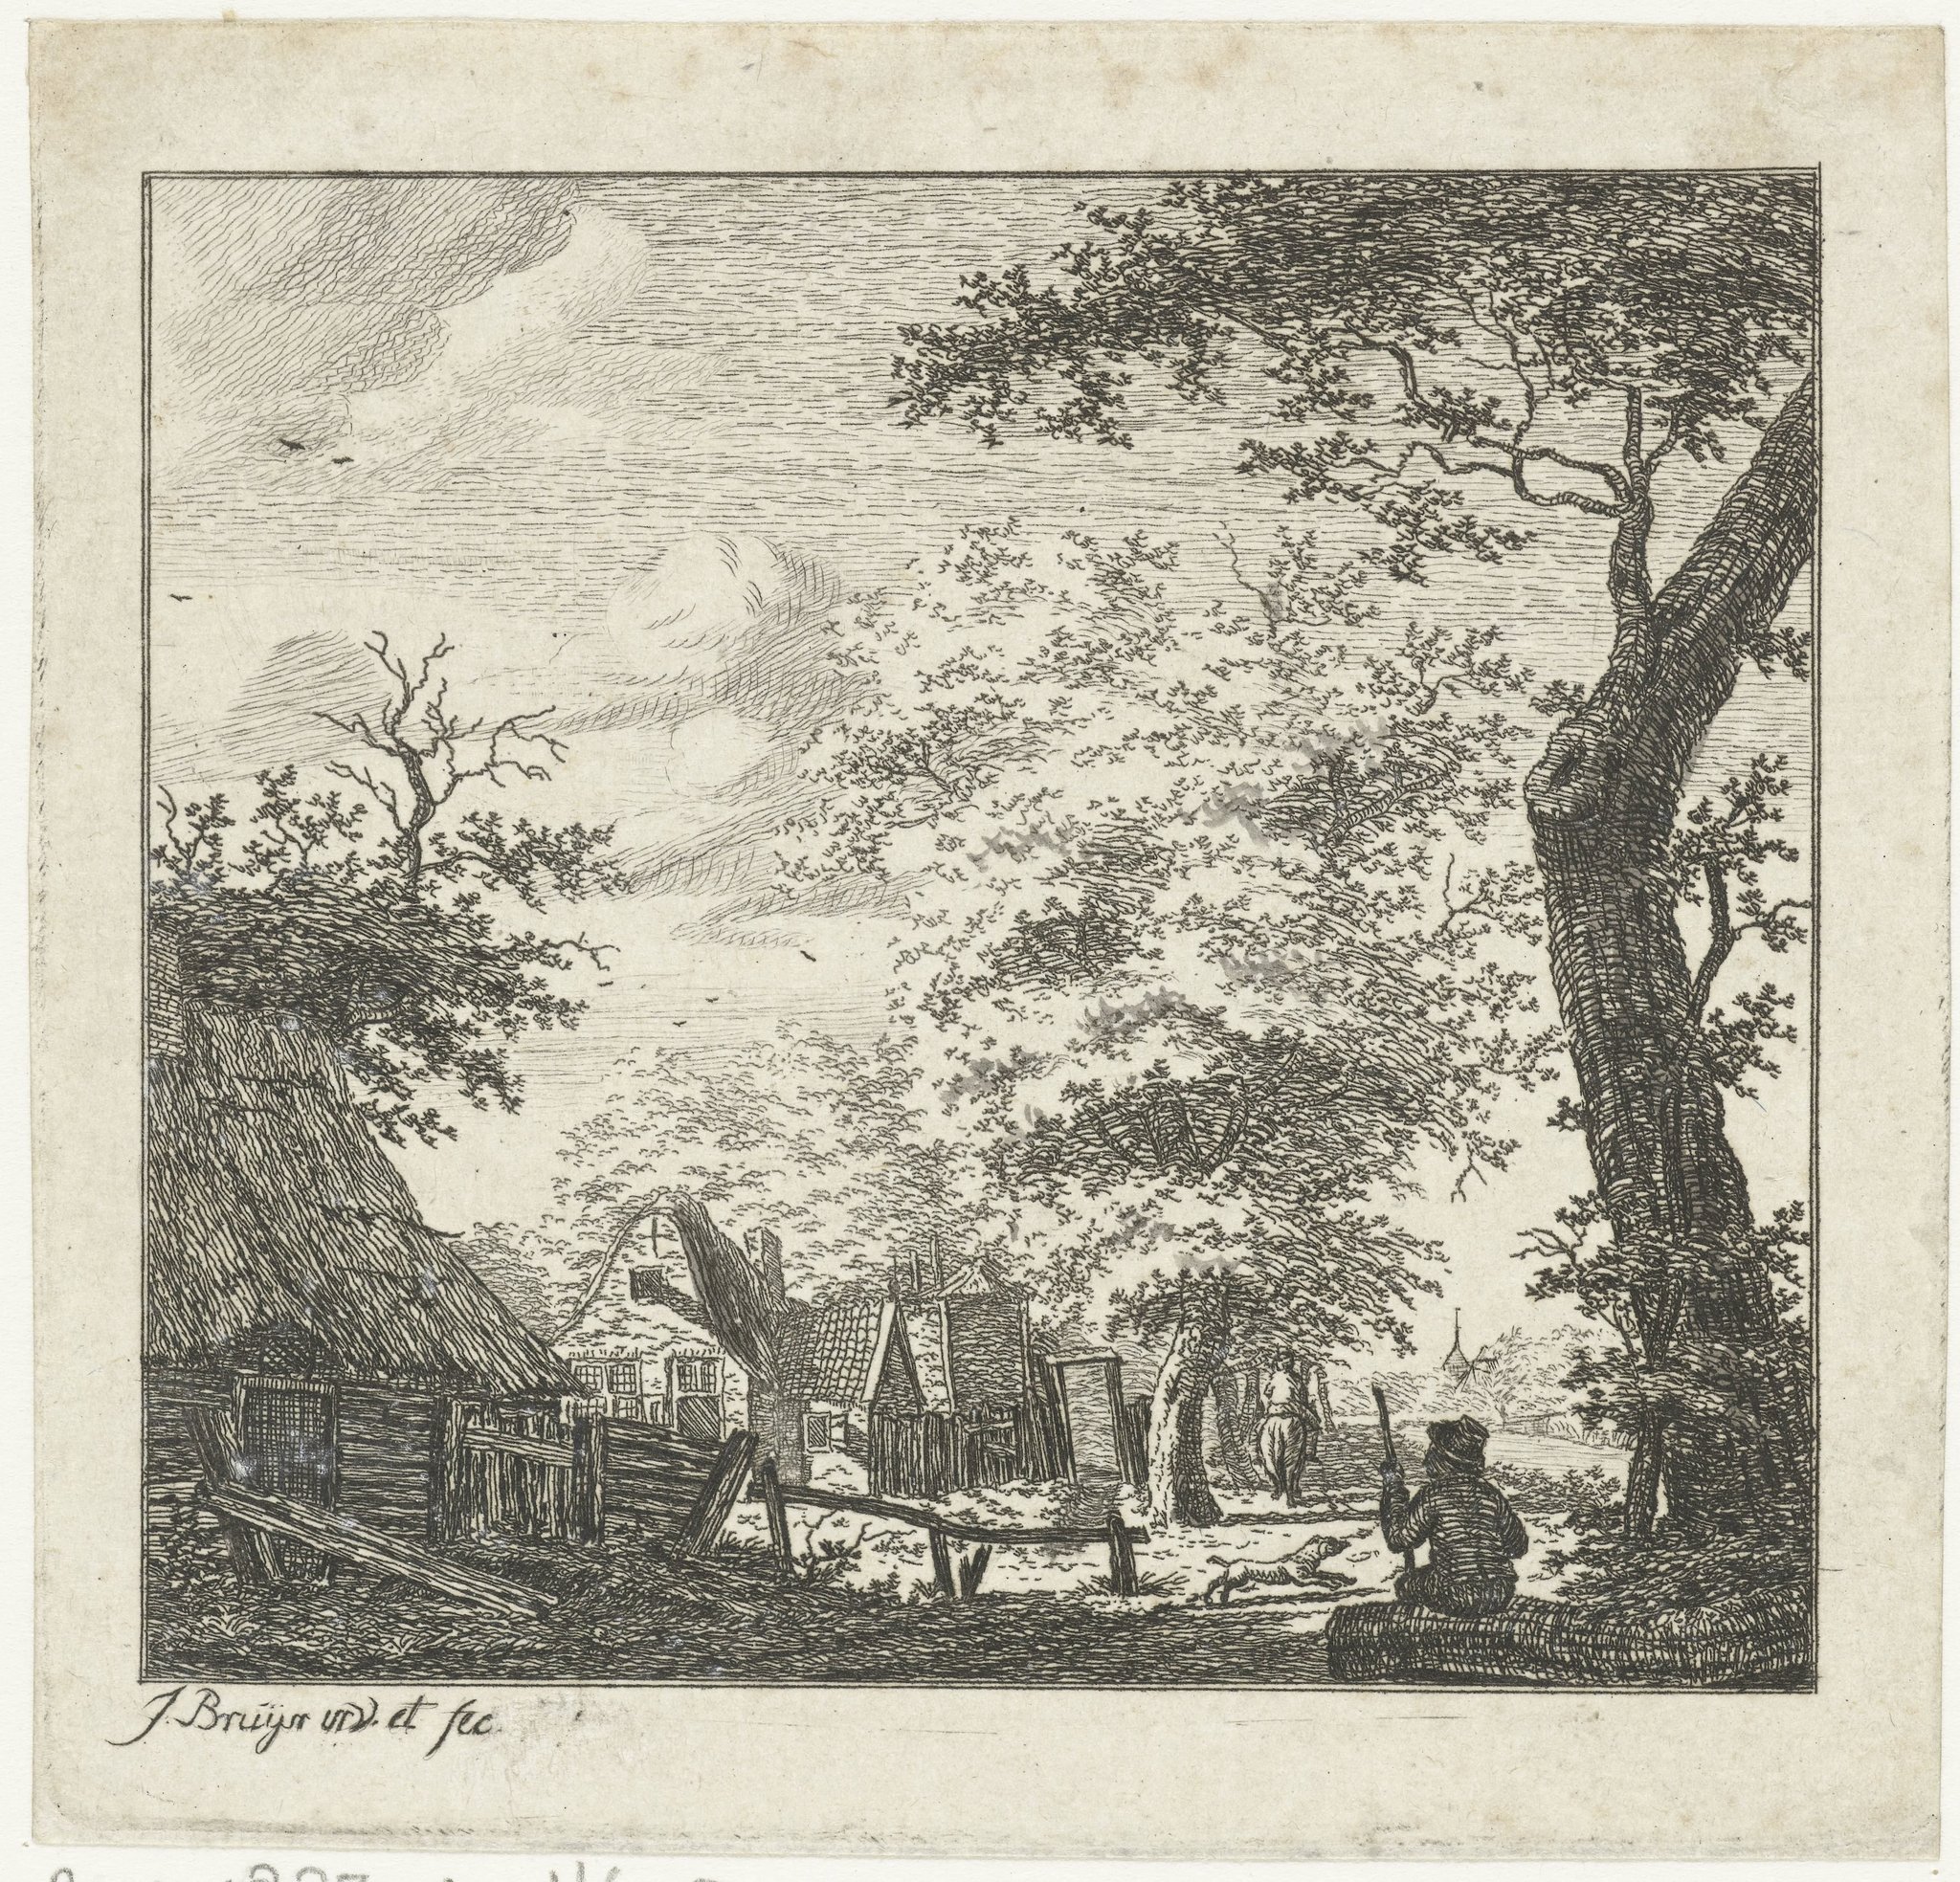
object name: print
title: Dorpsgezicht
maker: johanna de bruyn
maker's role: draughtsman, print maker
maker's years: 1722-1782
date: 1732-1782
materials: paper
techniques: etching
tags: public road in village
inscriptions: collector's mark: Lugt 2228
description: Gezicht op een weg langs de rand van een dorp. Links een rij boerenhuizen met rieten daken. Rechts een herder onder een boom. Op de weg rijdt een ruiter richting een kerktoren in de achtergrond.